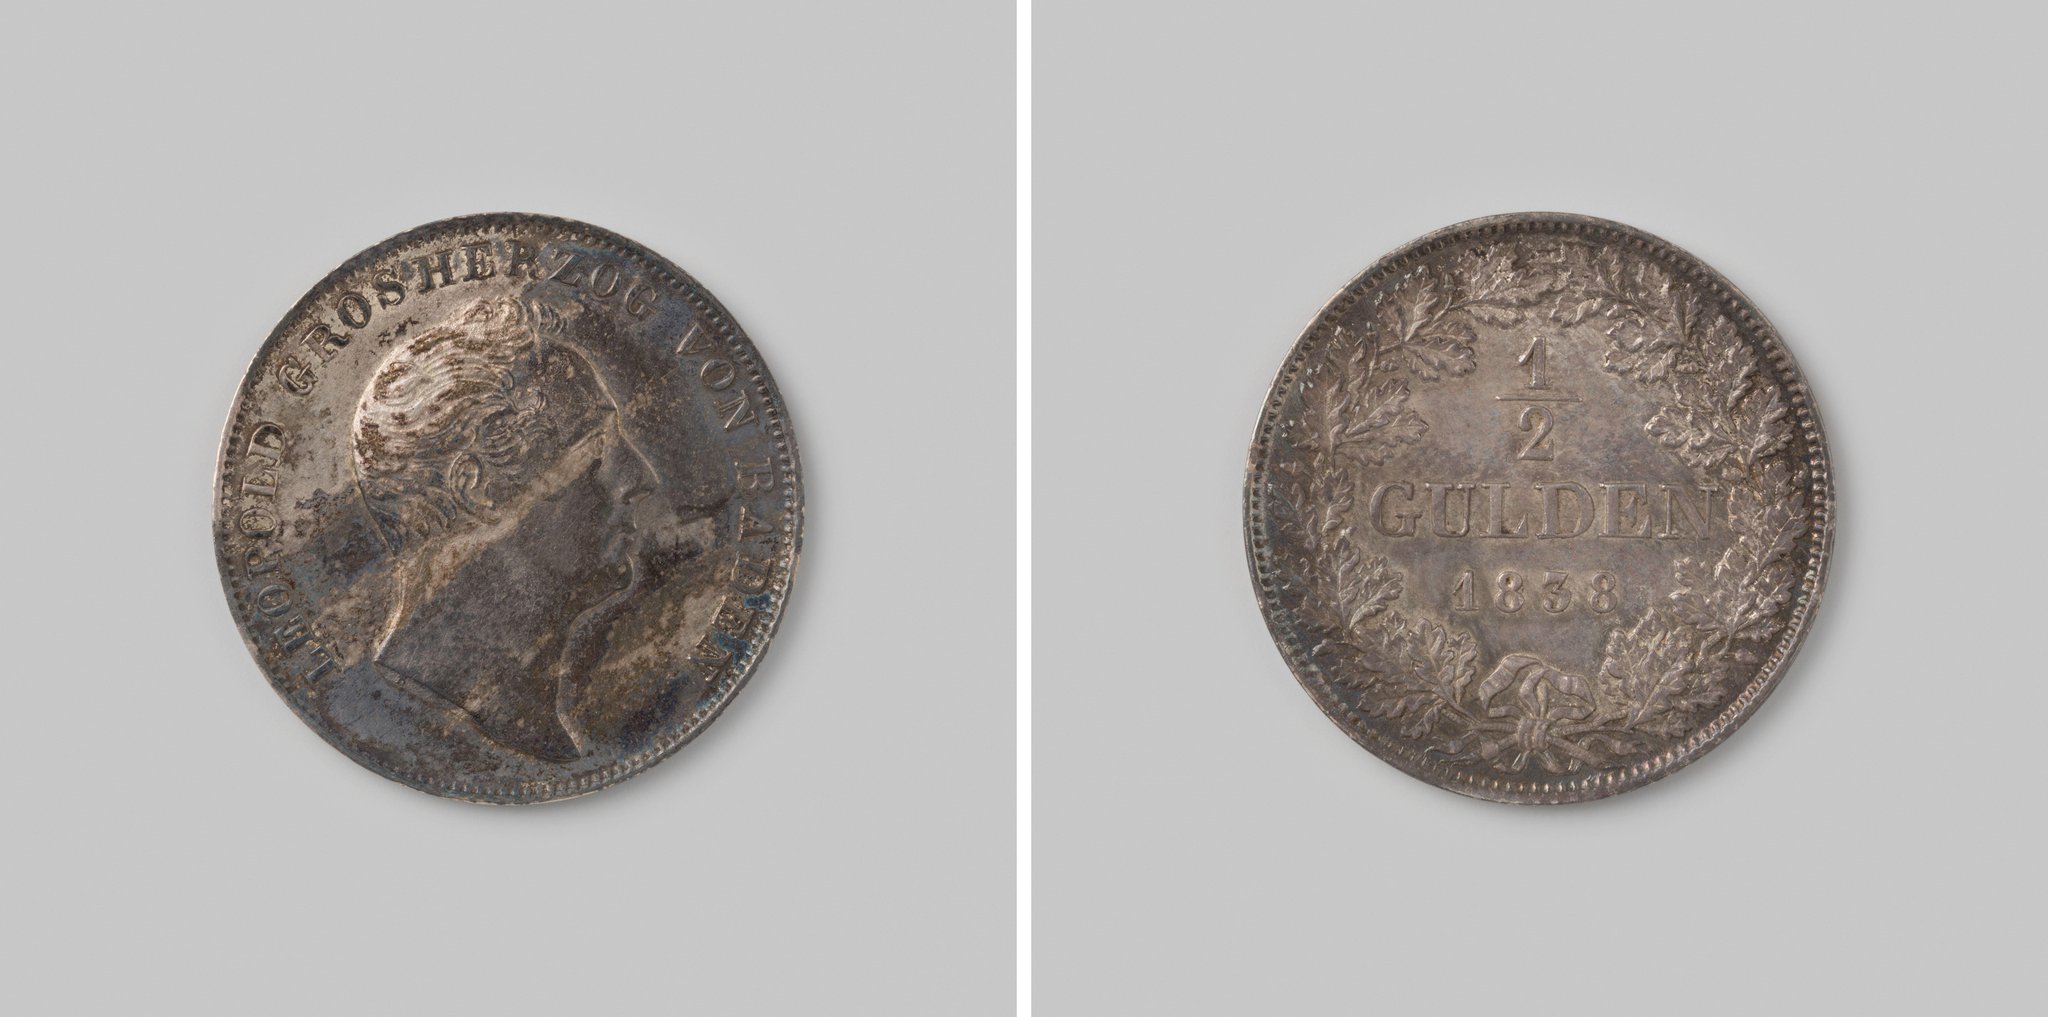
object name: coin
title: ½ Gulden uit het groothertogdom Baden van Leopold, 1838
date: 1838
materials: silver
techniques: striking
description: Zilveren munt. Voorzijde: hoofd van de groothertog naar rechts. Keerzijde: binnen twee samengebonden takken waarde-aanduiding in twee regels. Daaronder jaartal. Kartelrand.